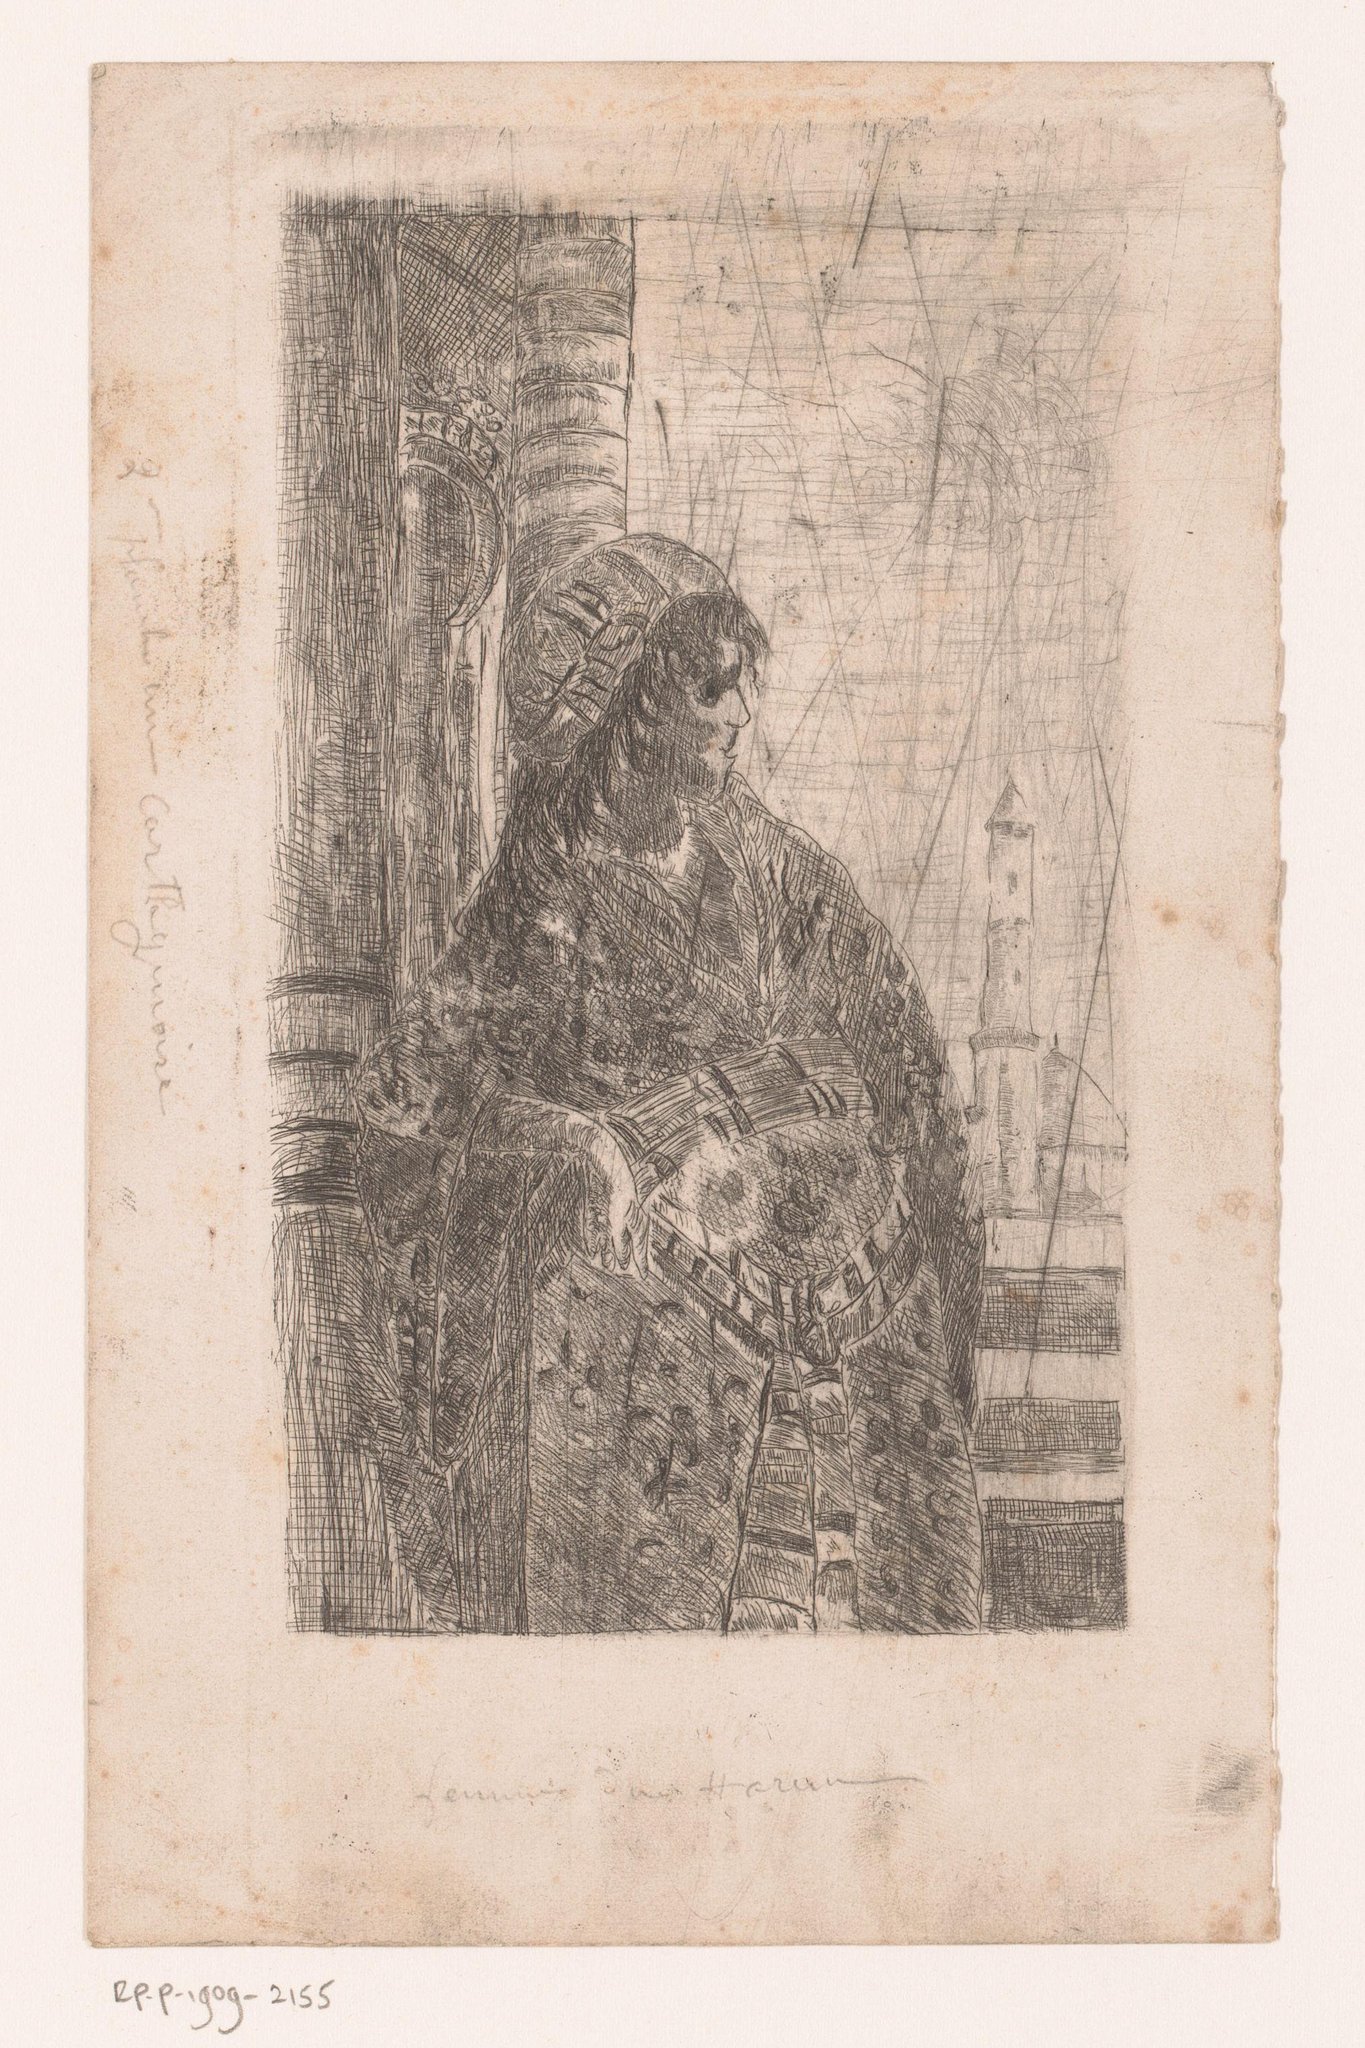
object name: drawing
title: Souvenirs uit Tunis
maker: vicomte arthur-jean le bailly dinghuem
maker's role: print maker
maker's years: 1839-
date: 1875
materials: paper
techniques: etching, intaglio, roulette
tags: adult woman, temple, shrine ~ islam, mohammedanism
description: Onderdeel van een serie van twaalf prenten.